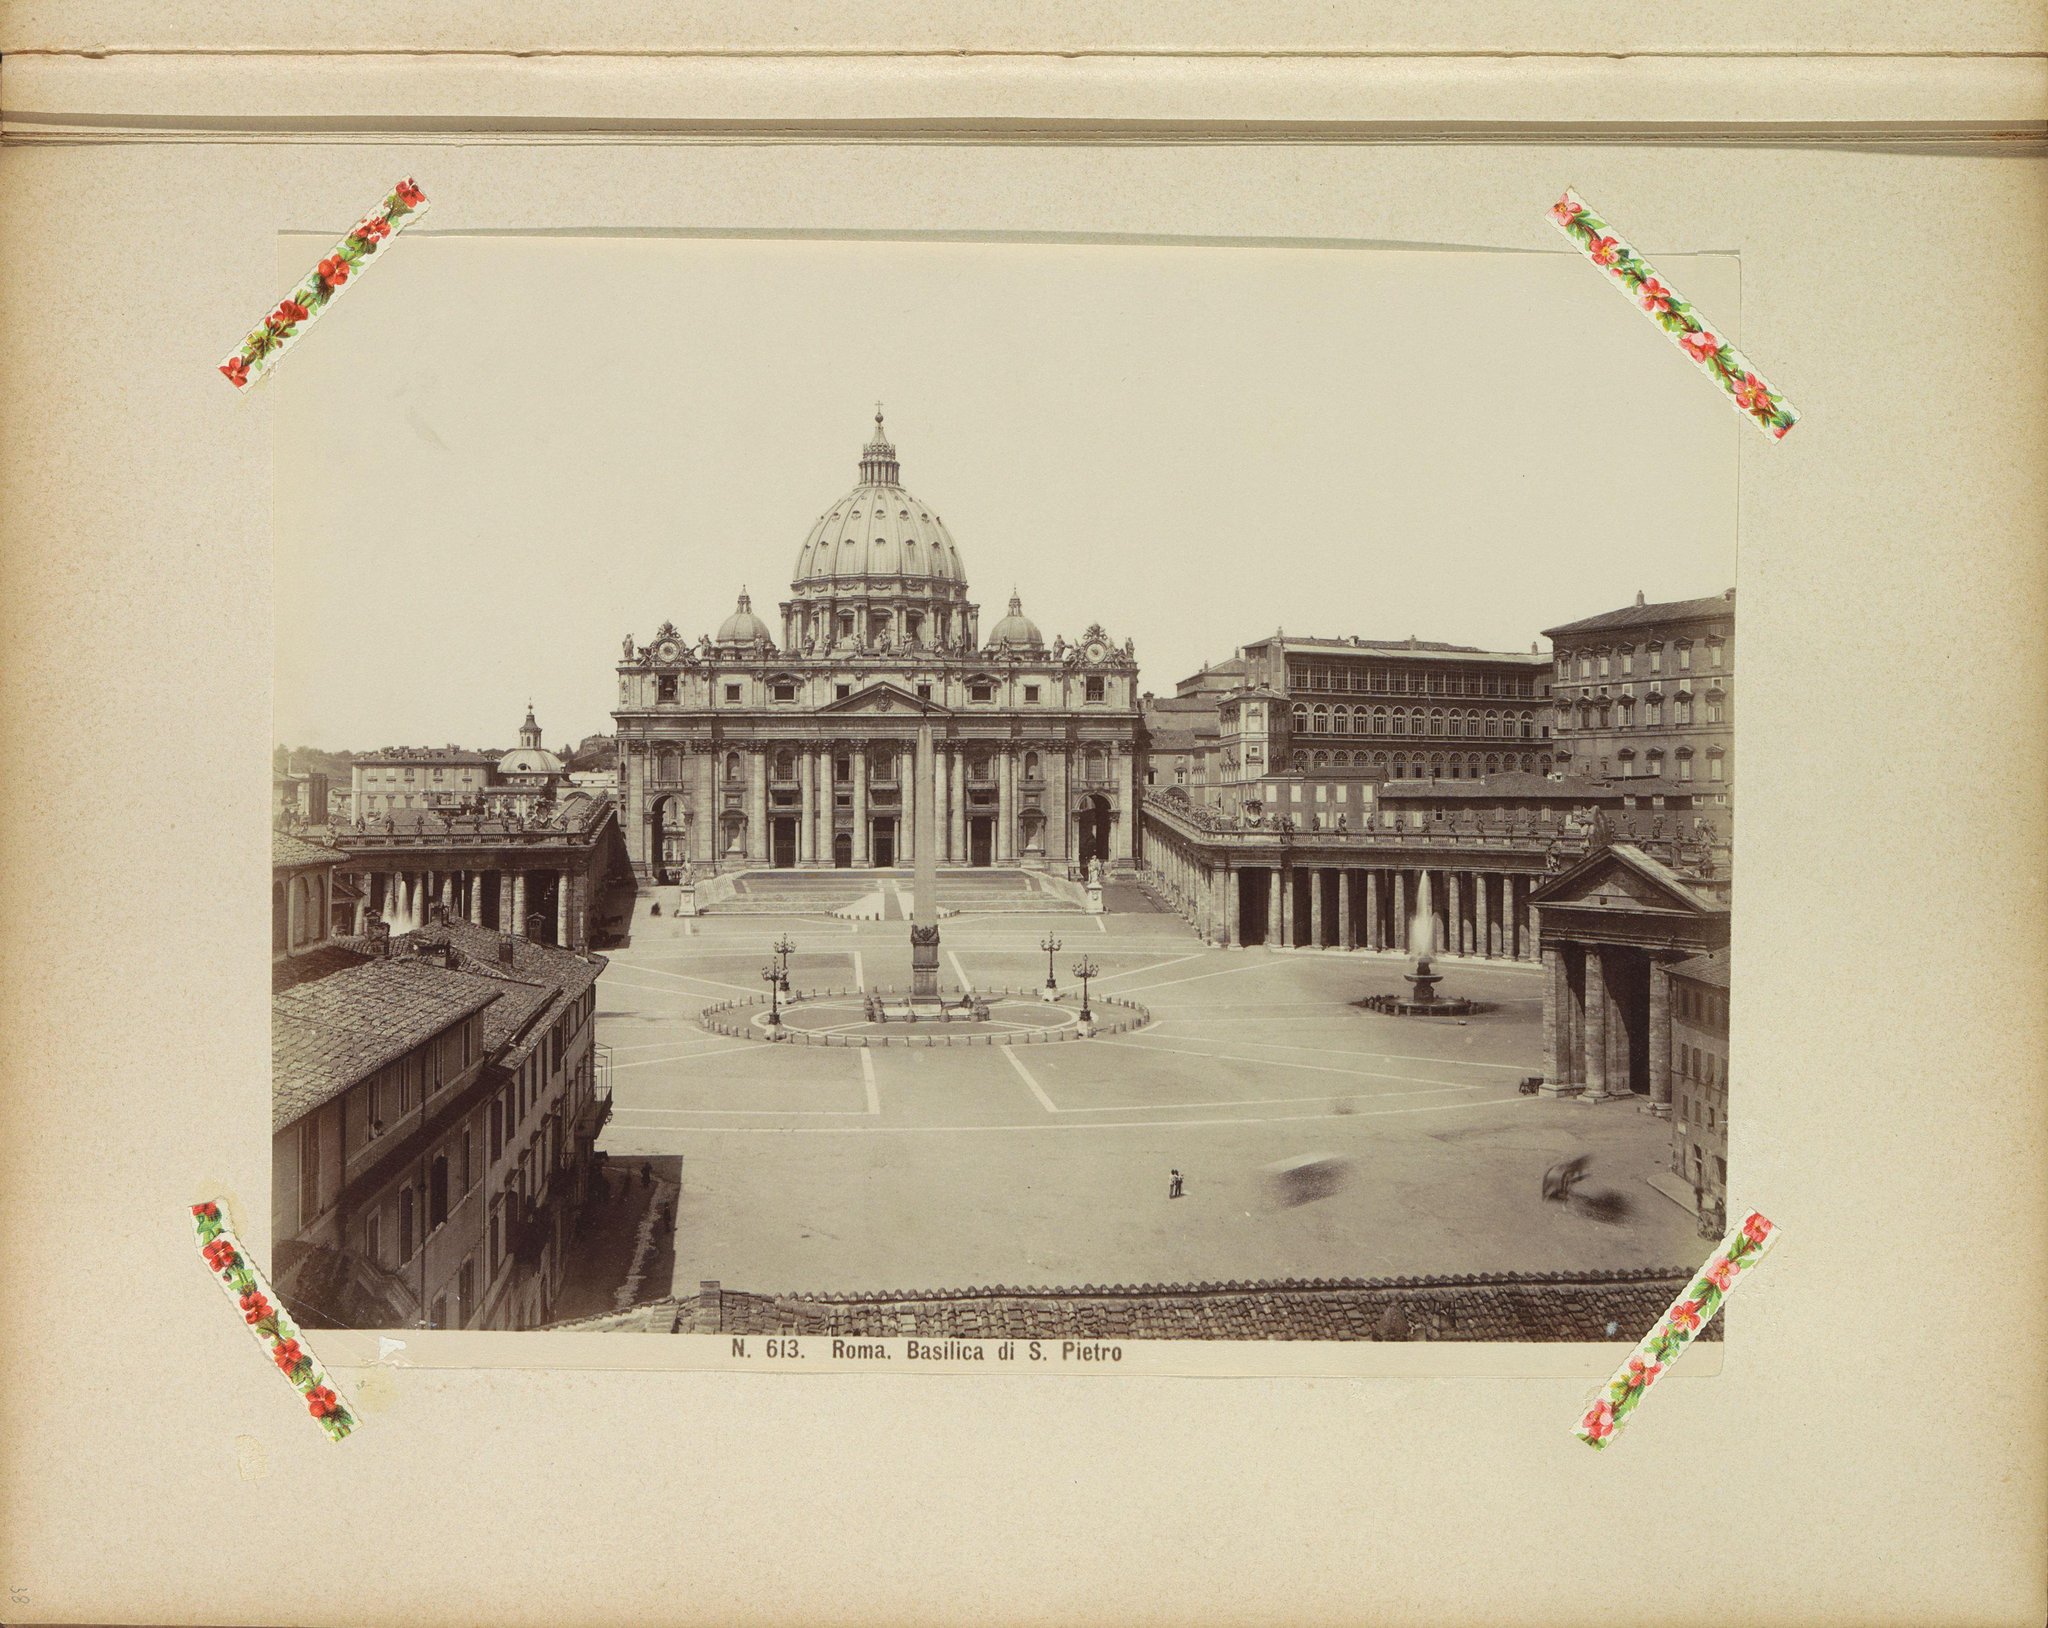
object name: photograph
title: Gezicht op het Sint-Pietersplein in Vaticaanstad met de Sint-Pietersbasiliek, de obelisk en (rechts) het Apostolisch Paleis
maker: Anonymous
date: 1860-1900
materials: photographic support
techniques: albumen print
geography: sint-pietersplein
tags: palace, church (exterior), monument, statue, dome ~ architecture, square, place, circus, etc. (+ city(-scape) with figures, staffage)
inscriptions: number: ‘613’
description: Onderdeel van Fotoalbum met opnames van bezienswaardigheden in Italiaanse steden en van kunstwerken.